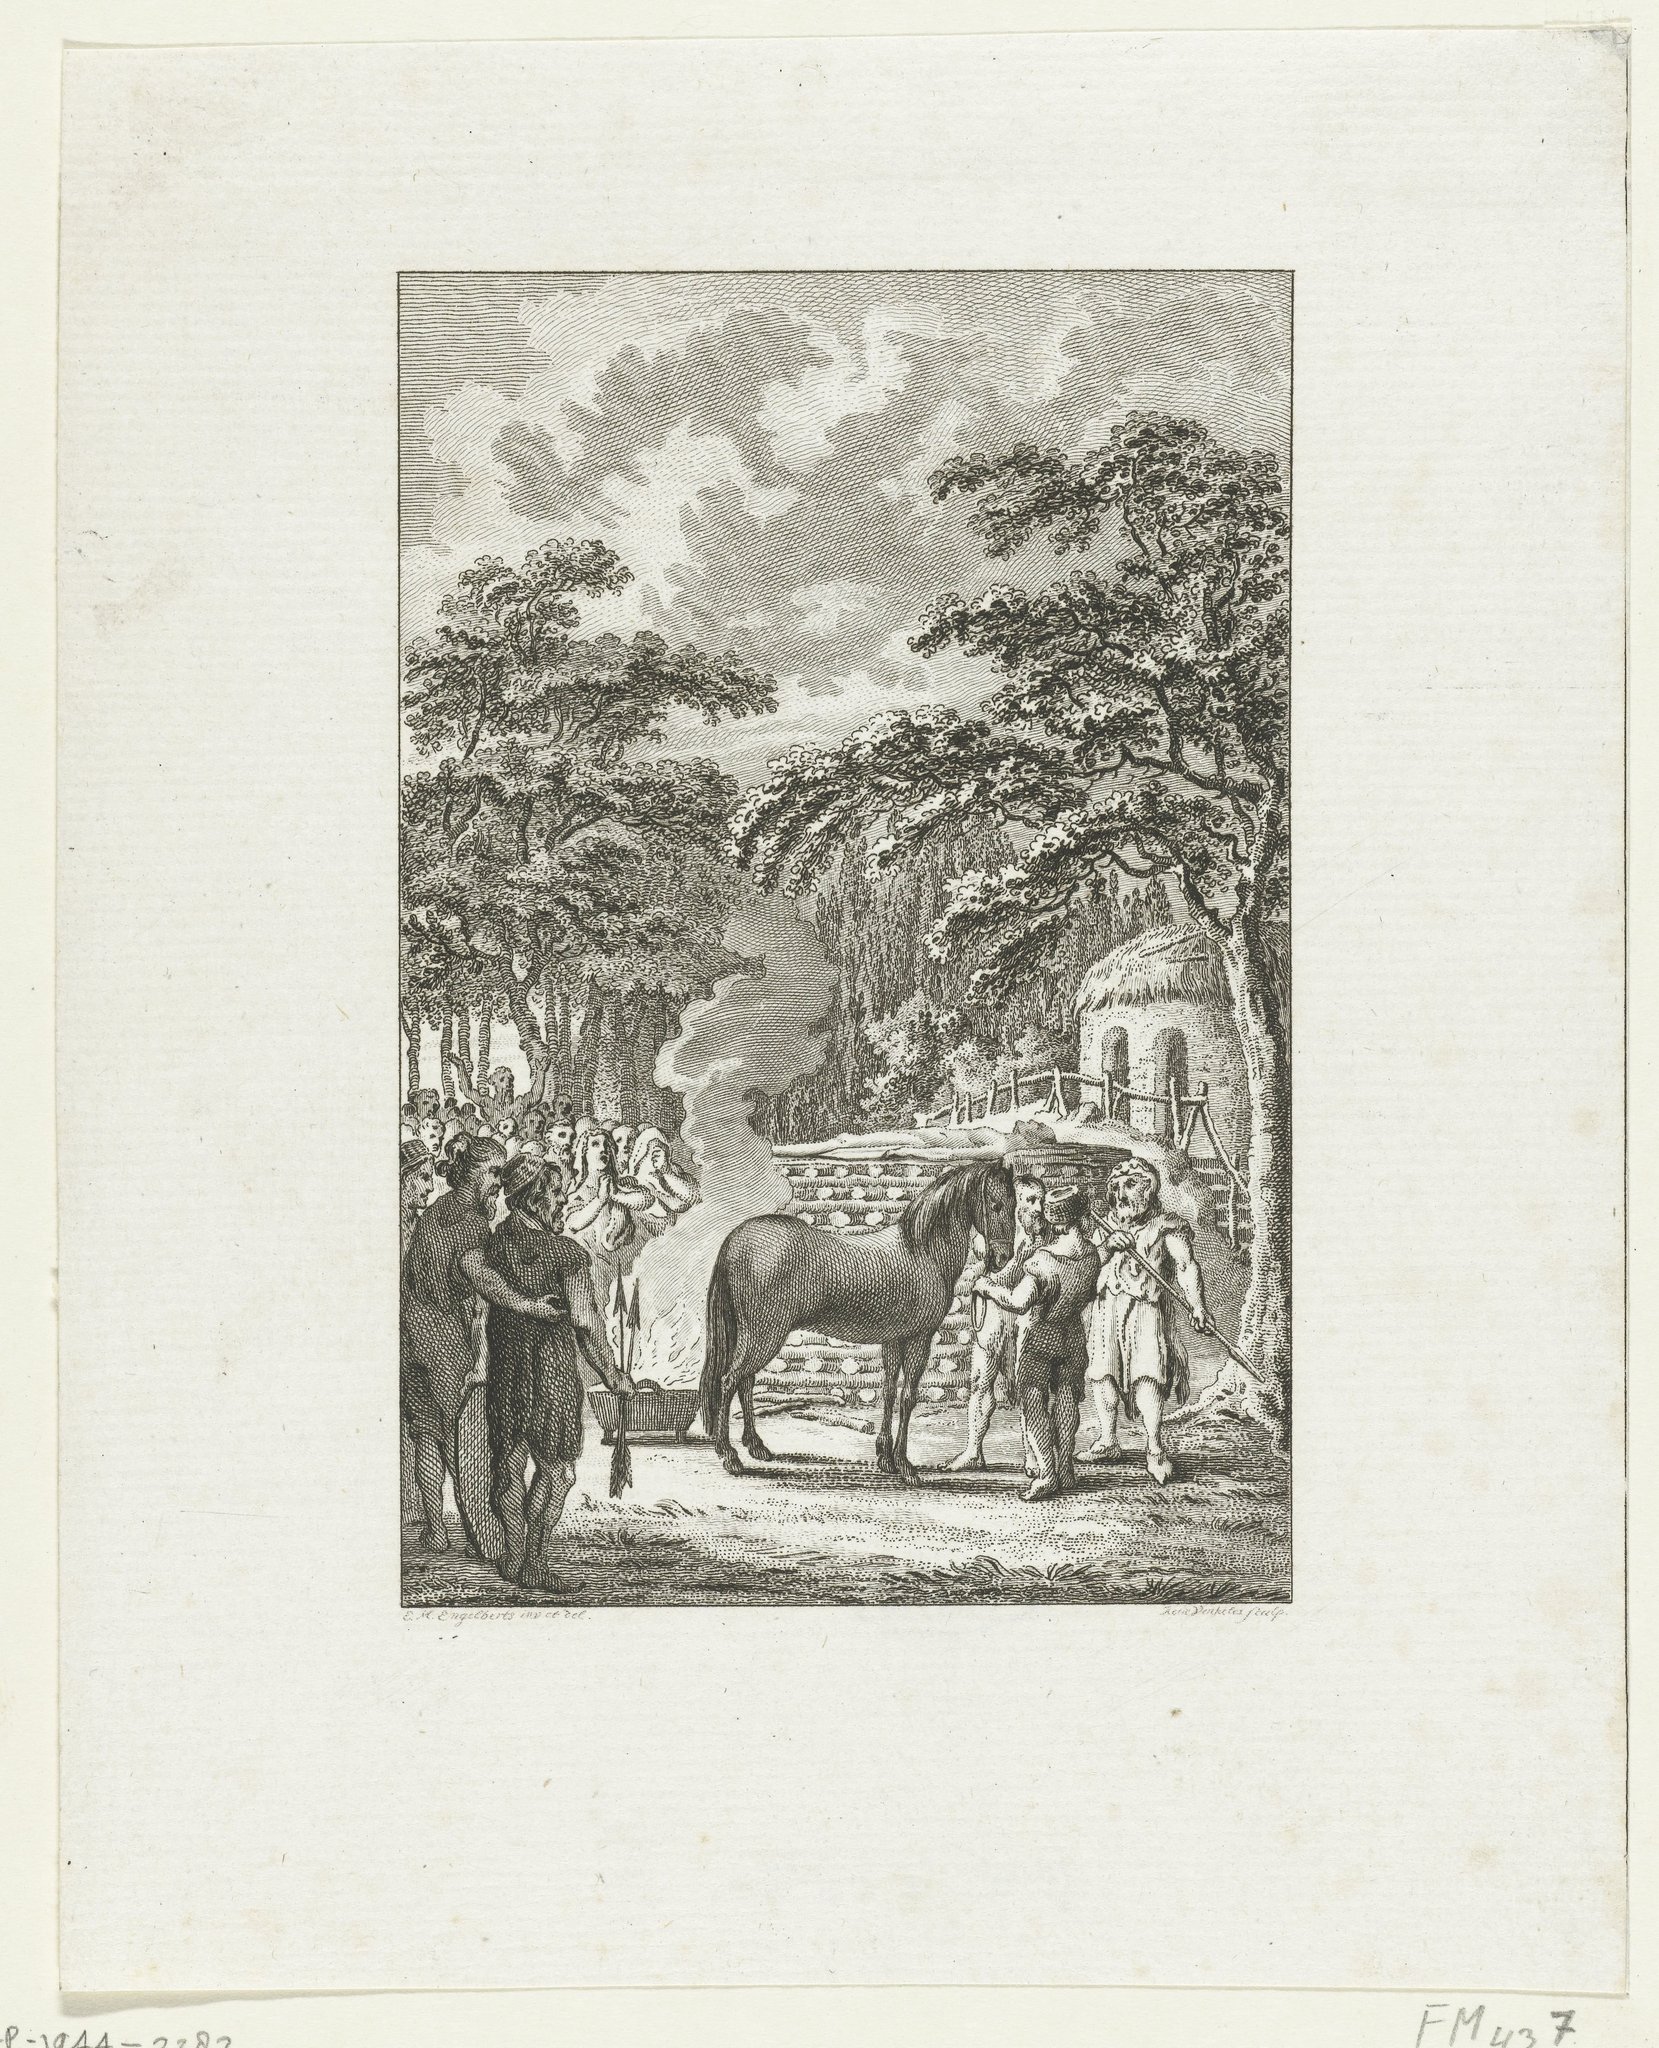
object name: history print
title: Lijkplechtigheid bij de Bataven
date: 1788-1790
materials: paper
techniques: etching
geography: netherlands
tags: funerary ceremonial, extinct, 'historical' peoples (with name), netherlands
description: Illustratie voor: E.M. Engelberts, De aloude staat en geschiedenissen der Vereenigde Nederlanden, Johannes Allart, Amsterdam 1784-1799, dl. III, p. 156. Staat vóór de letter.